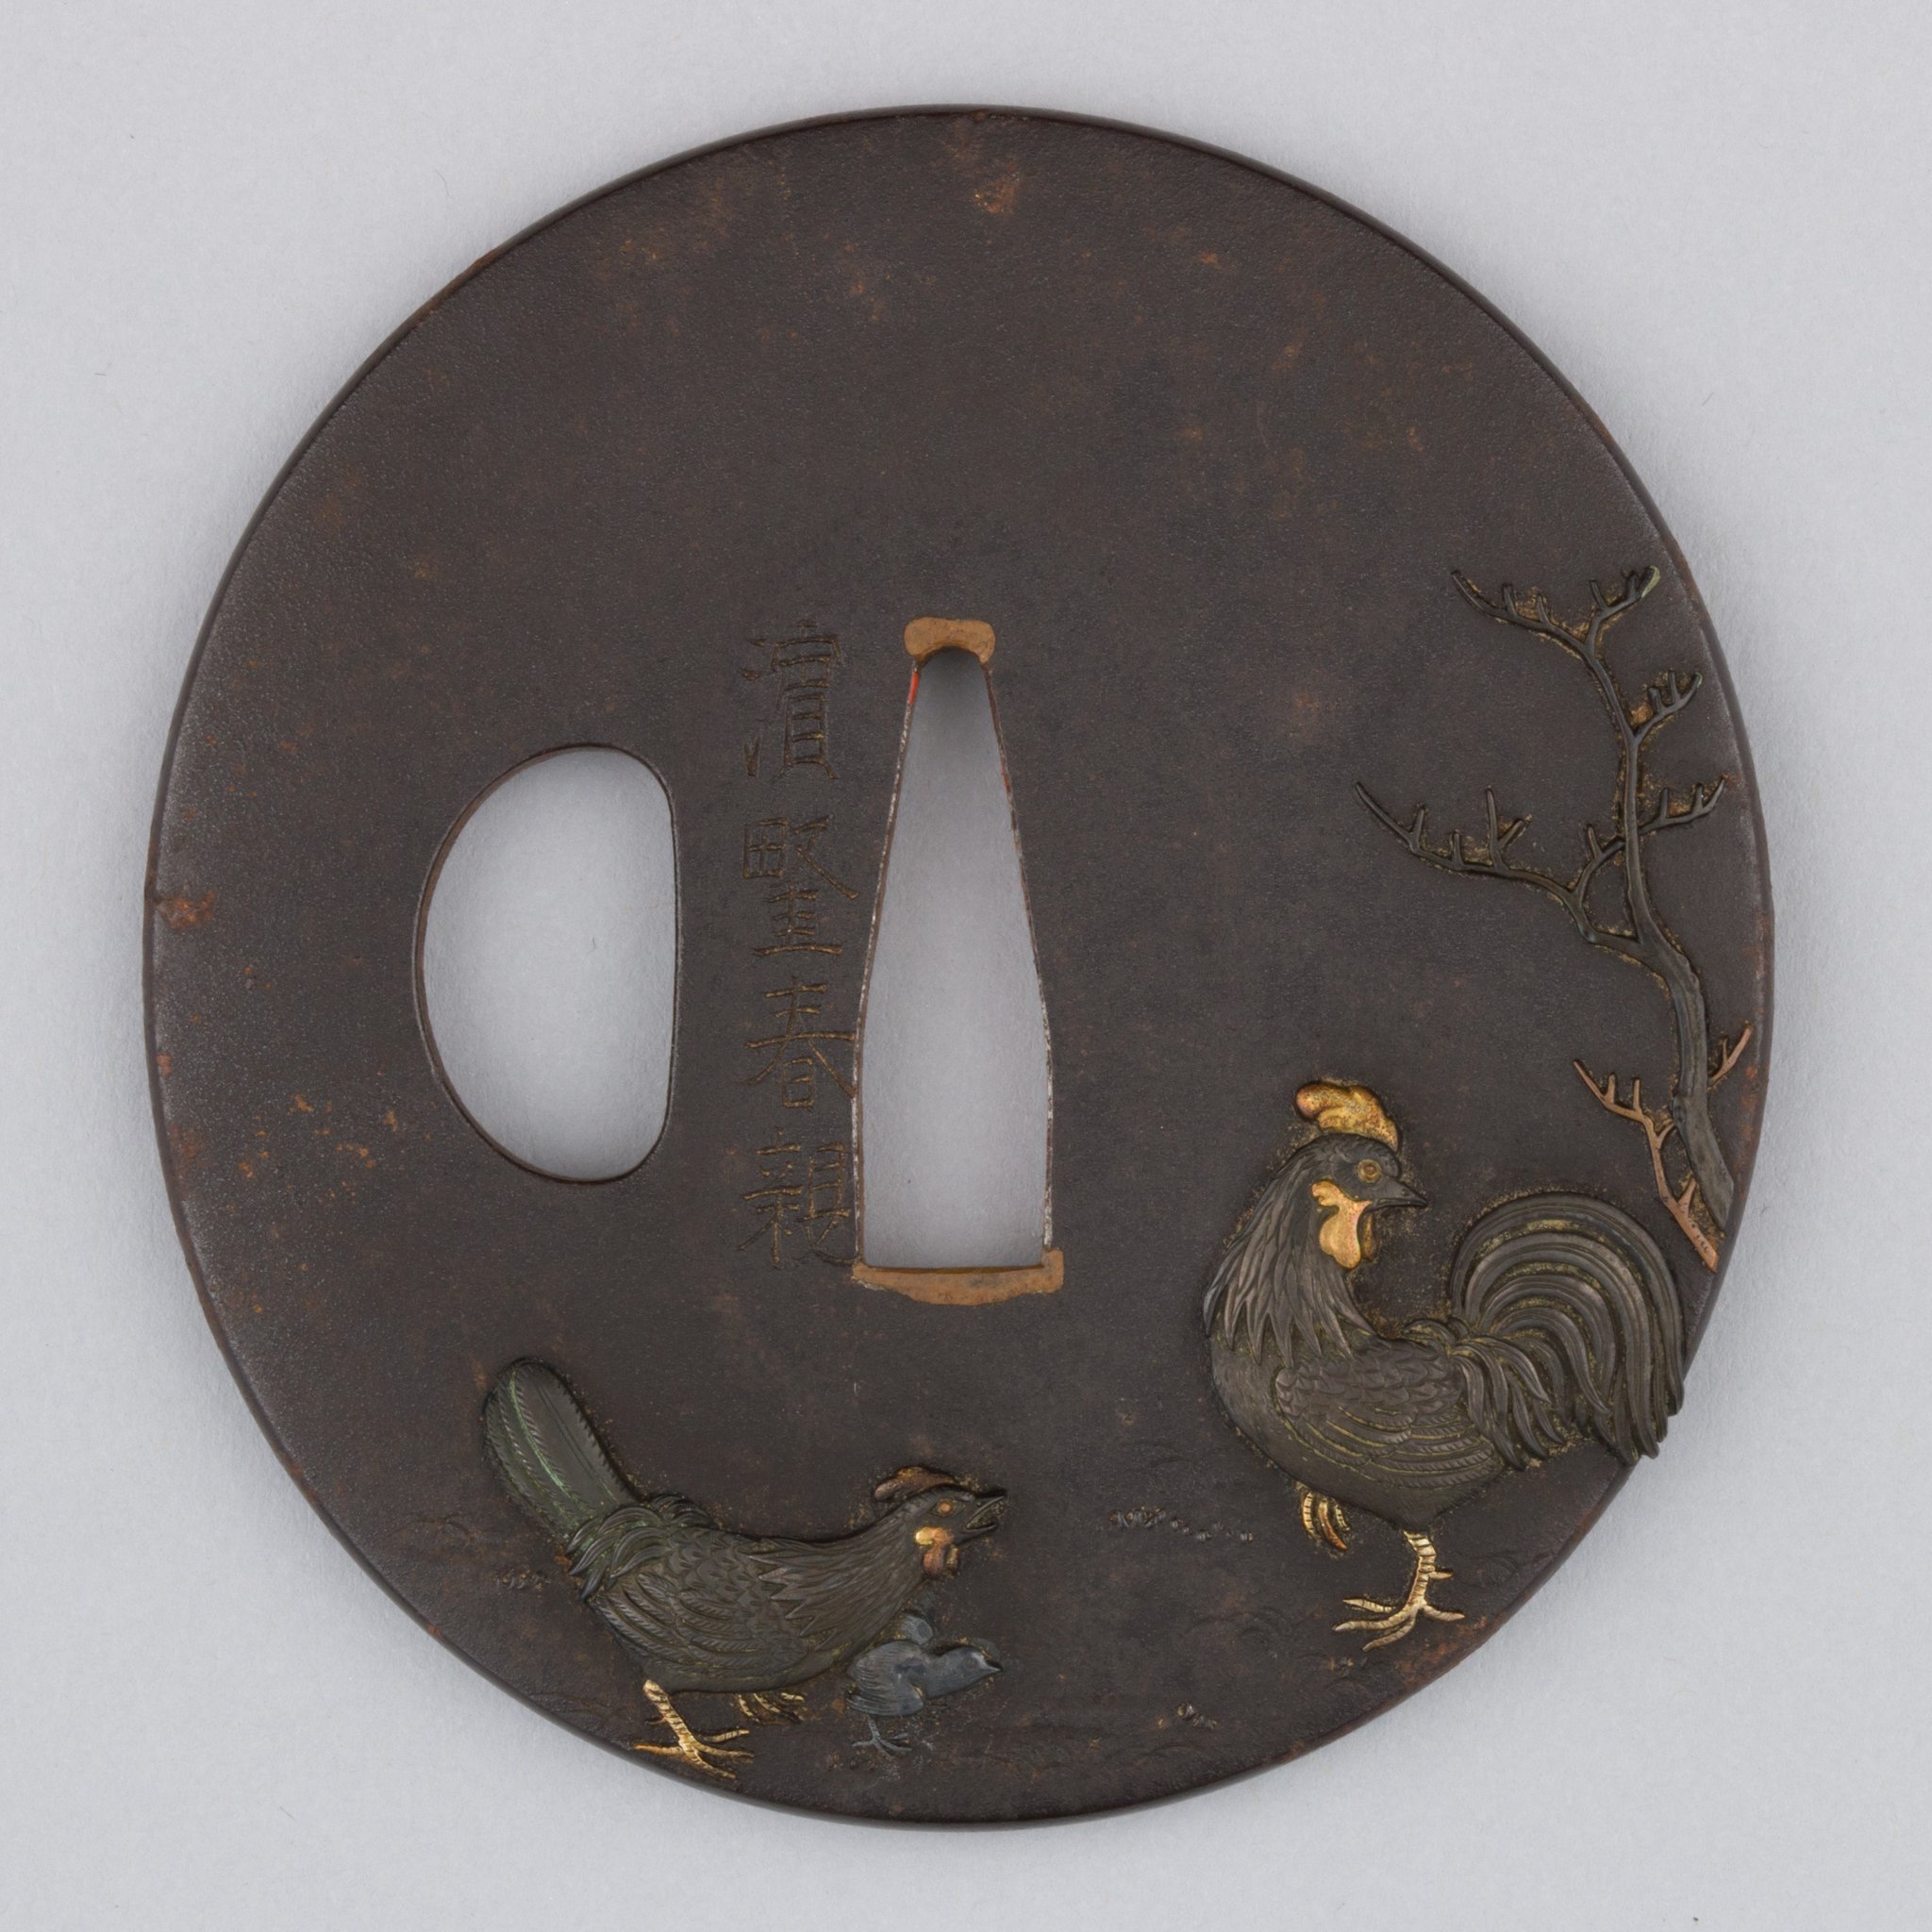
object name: sword guard tsuba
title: Sword Guard (Tsuba)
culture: japanese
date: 1615-1868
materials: copper, silver alloy, gold, iron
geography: japan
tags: roosters